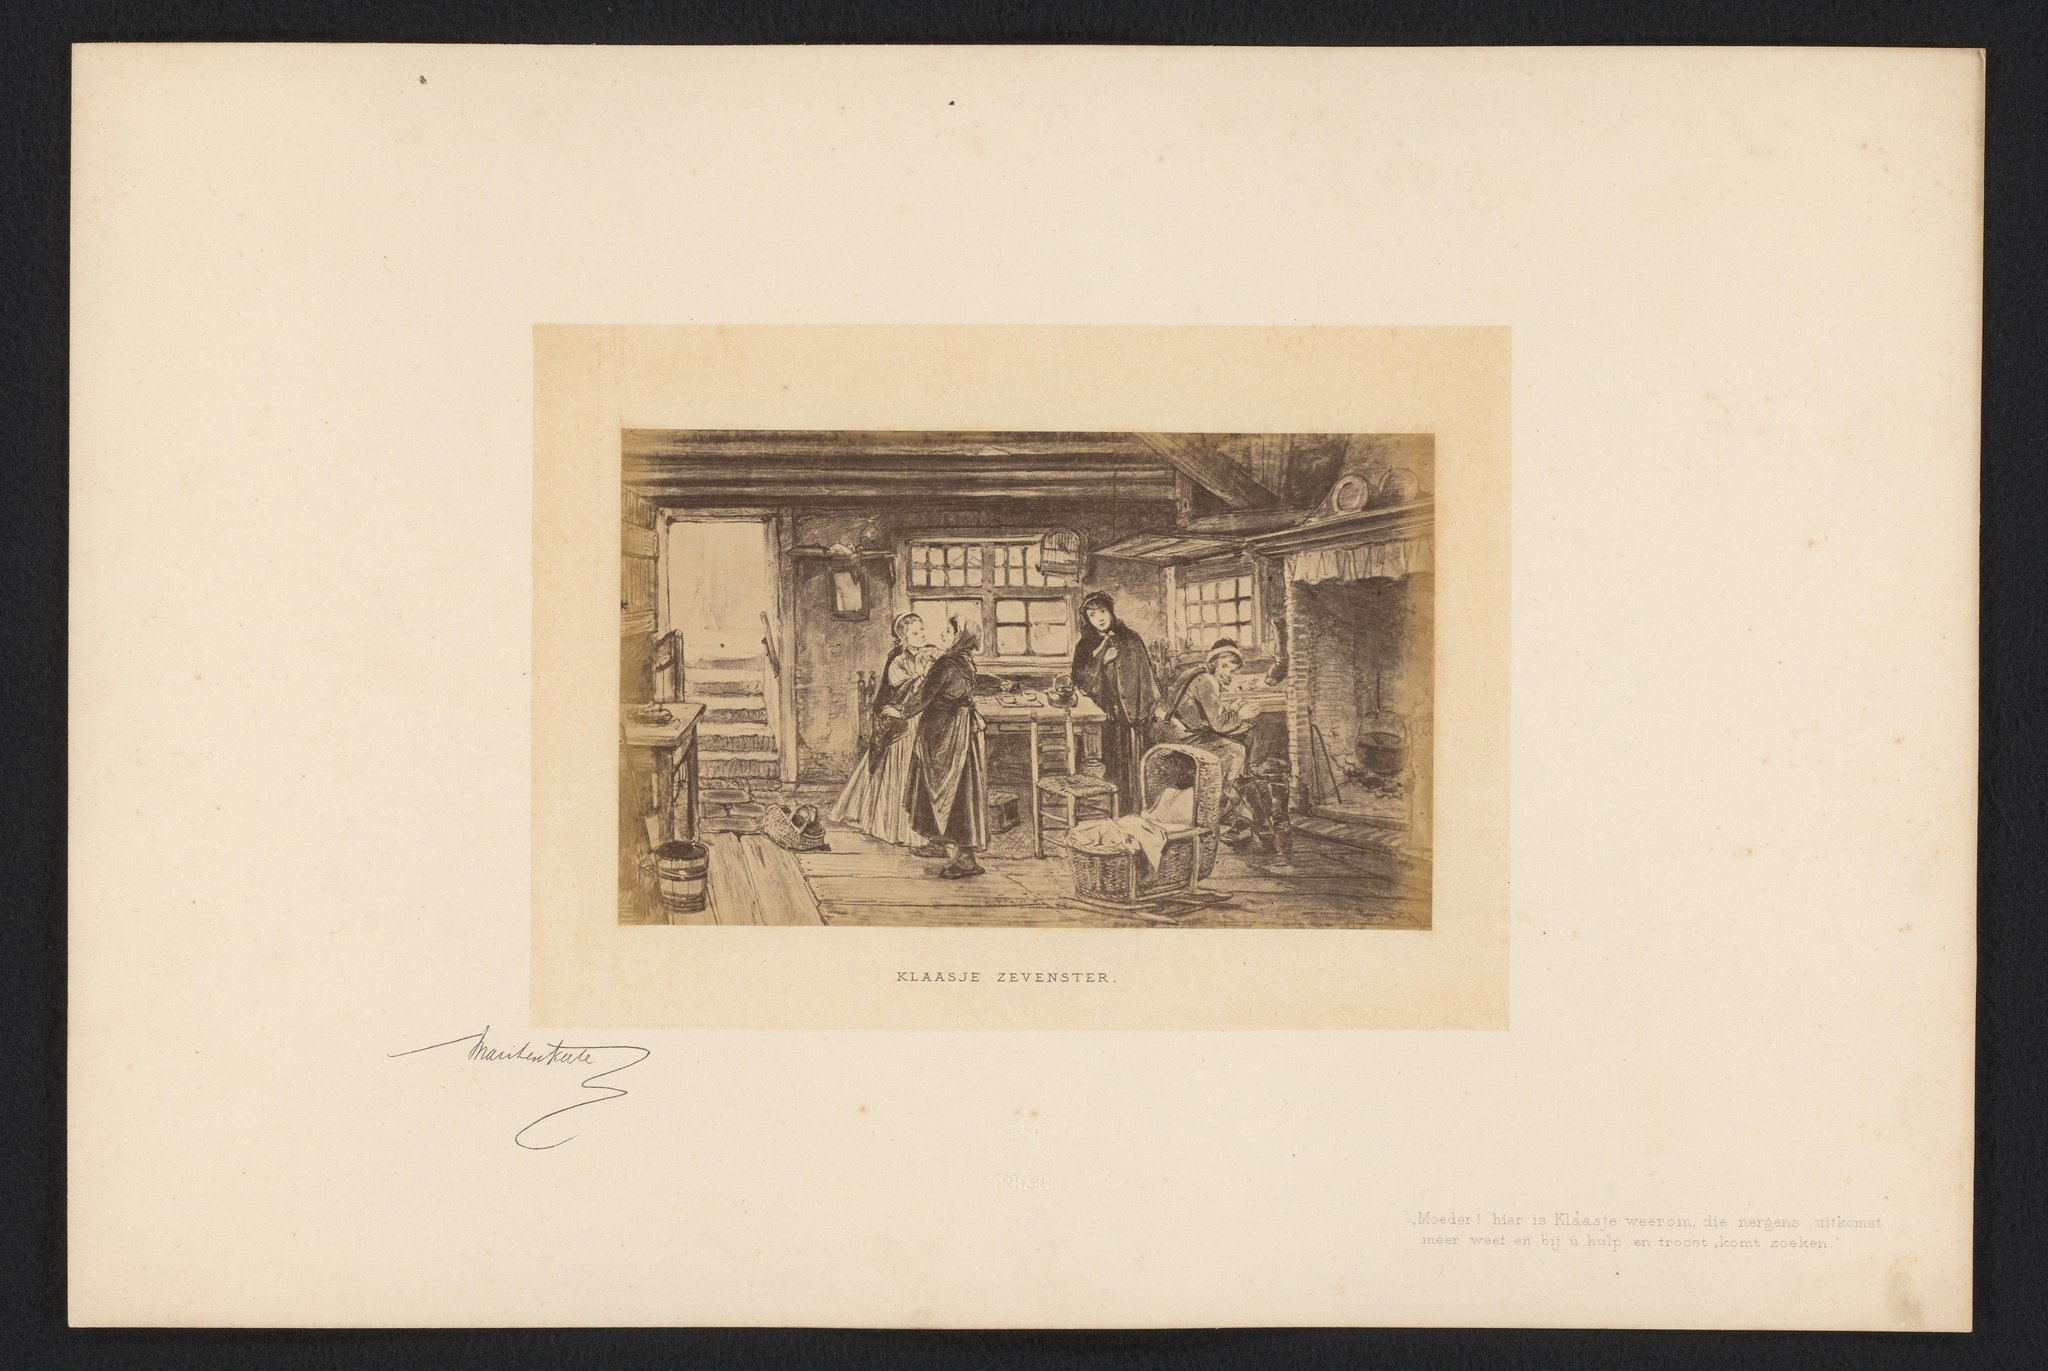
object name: photograph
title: Klaasje Zevenster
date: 1865-1870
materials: cardboard, paper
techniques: albumen print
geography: haarlem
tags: adult woman, interior of the house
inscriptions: signature: ‘Mari ten Kate’, check stamp: ‘Ch. B & C.’, inscription: ‘"Moeder! hier is (...) troost komt zoeken."’